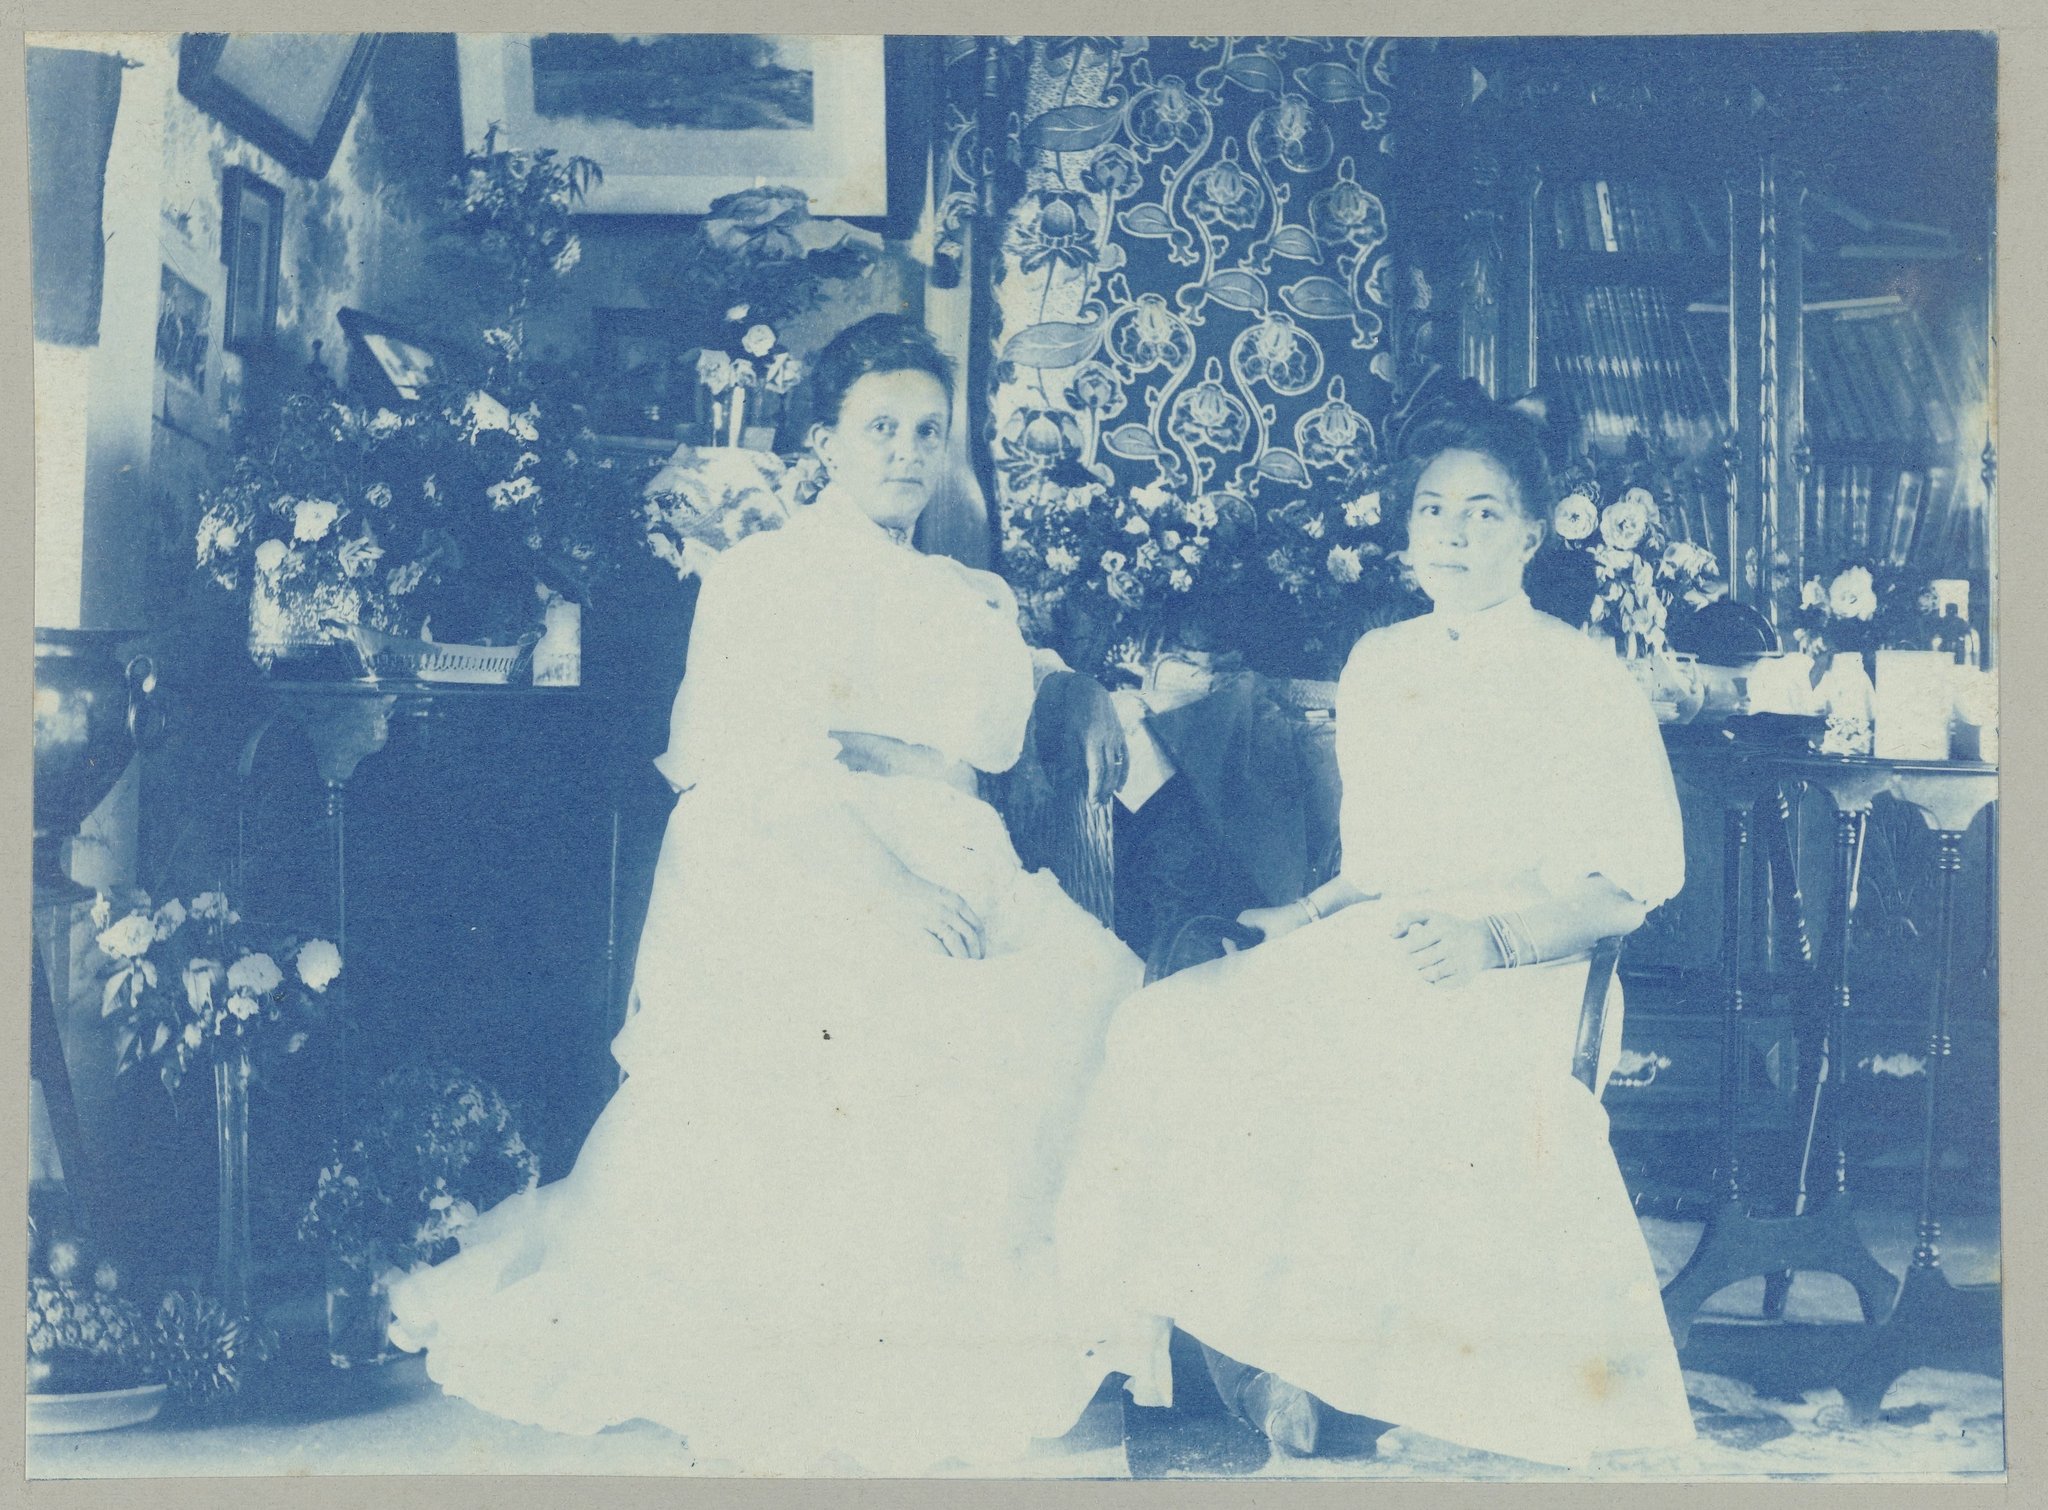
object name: photograph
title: In het huis in de Oranjestraat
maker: hendrik doijer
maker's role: engineer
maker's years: 1863-1925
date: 1903-1910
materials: photographic support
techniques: cyanotype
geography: suriname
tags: suriname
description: Familiefoto van moeder en dochter (van de familie Doijer?) in een kamer van het huis in de Oranjestraat te Paramaribo. Onderdeel van het fotoalbum Souvenir de Voyage (deel 2), over het leven van de familie Doijer in en rond de plantage Ma Retraite in Suriname in de jaren 1903-1910.